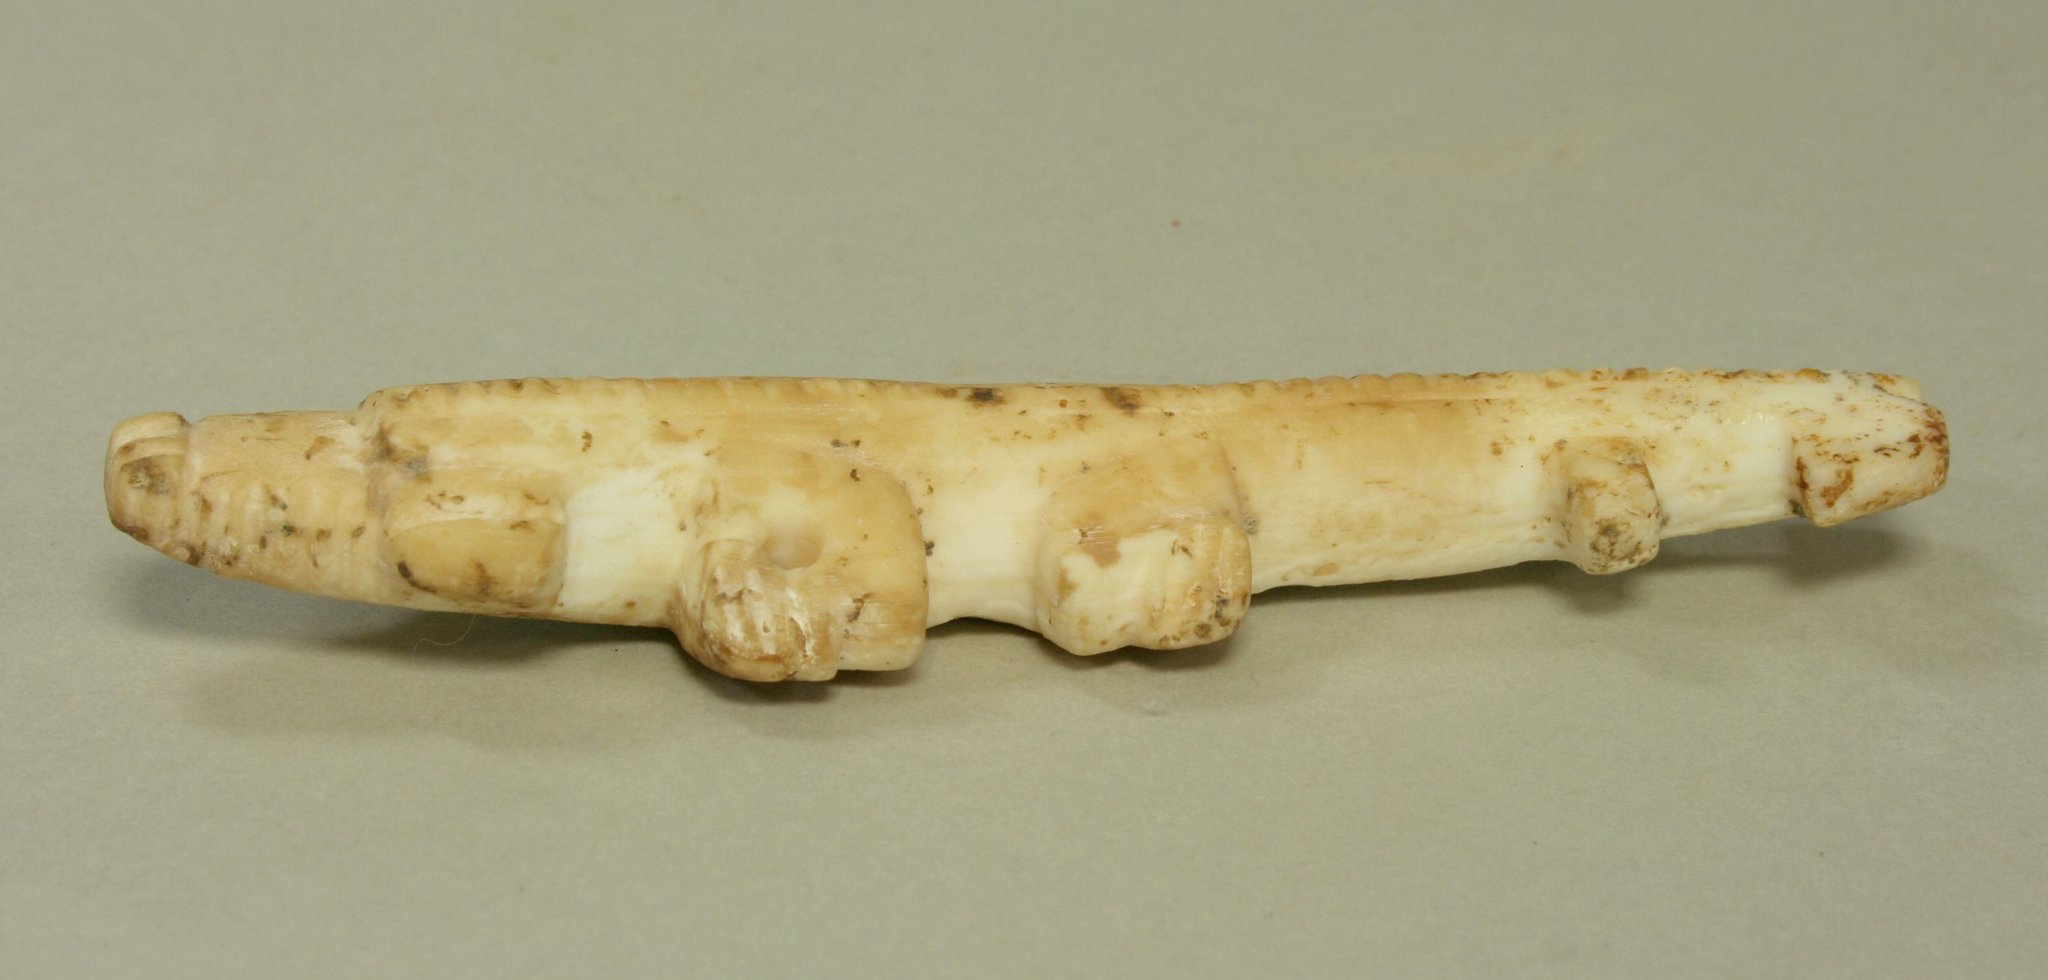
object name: pendant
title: Animal Pendant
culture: international or initial style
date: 401-1000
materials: shell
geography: panama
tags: animals